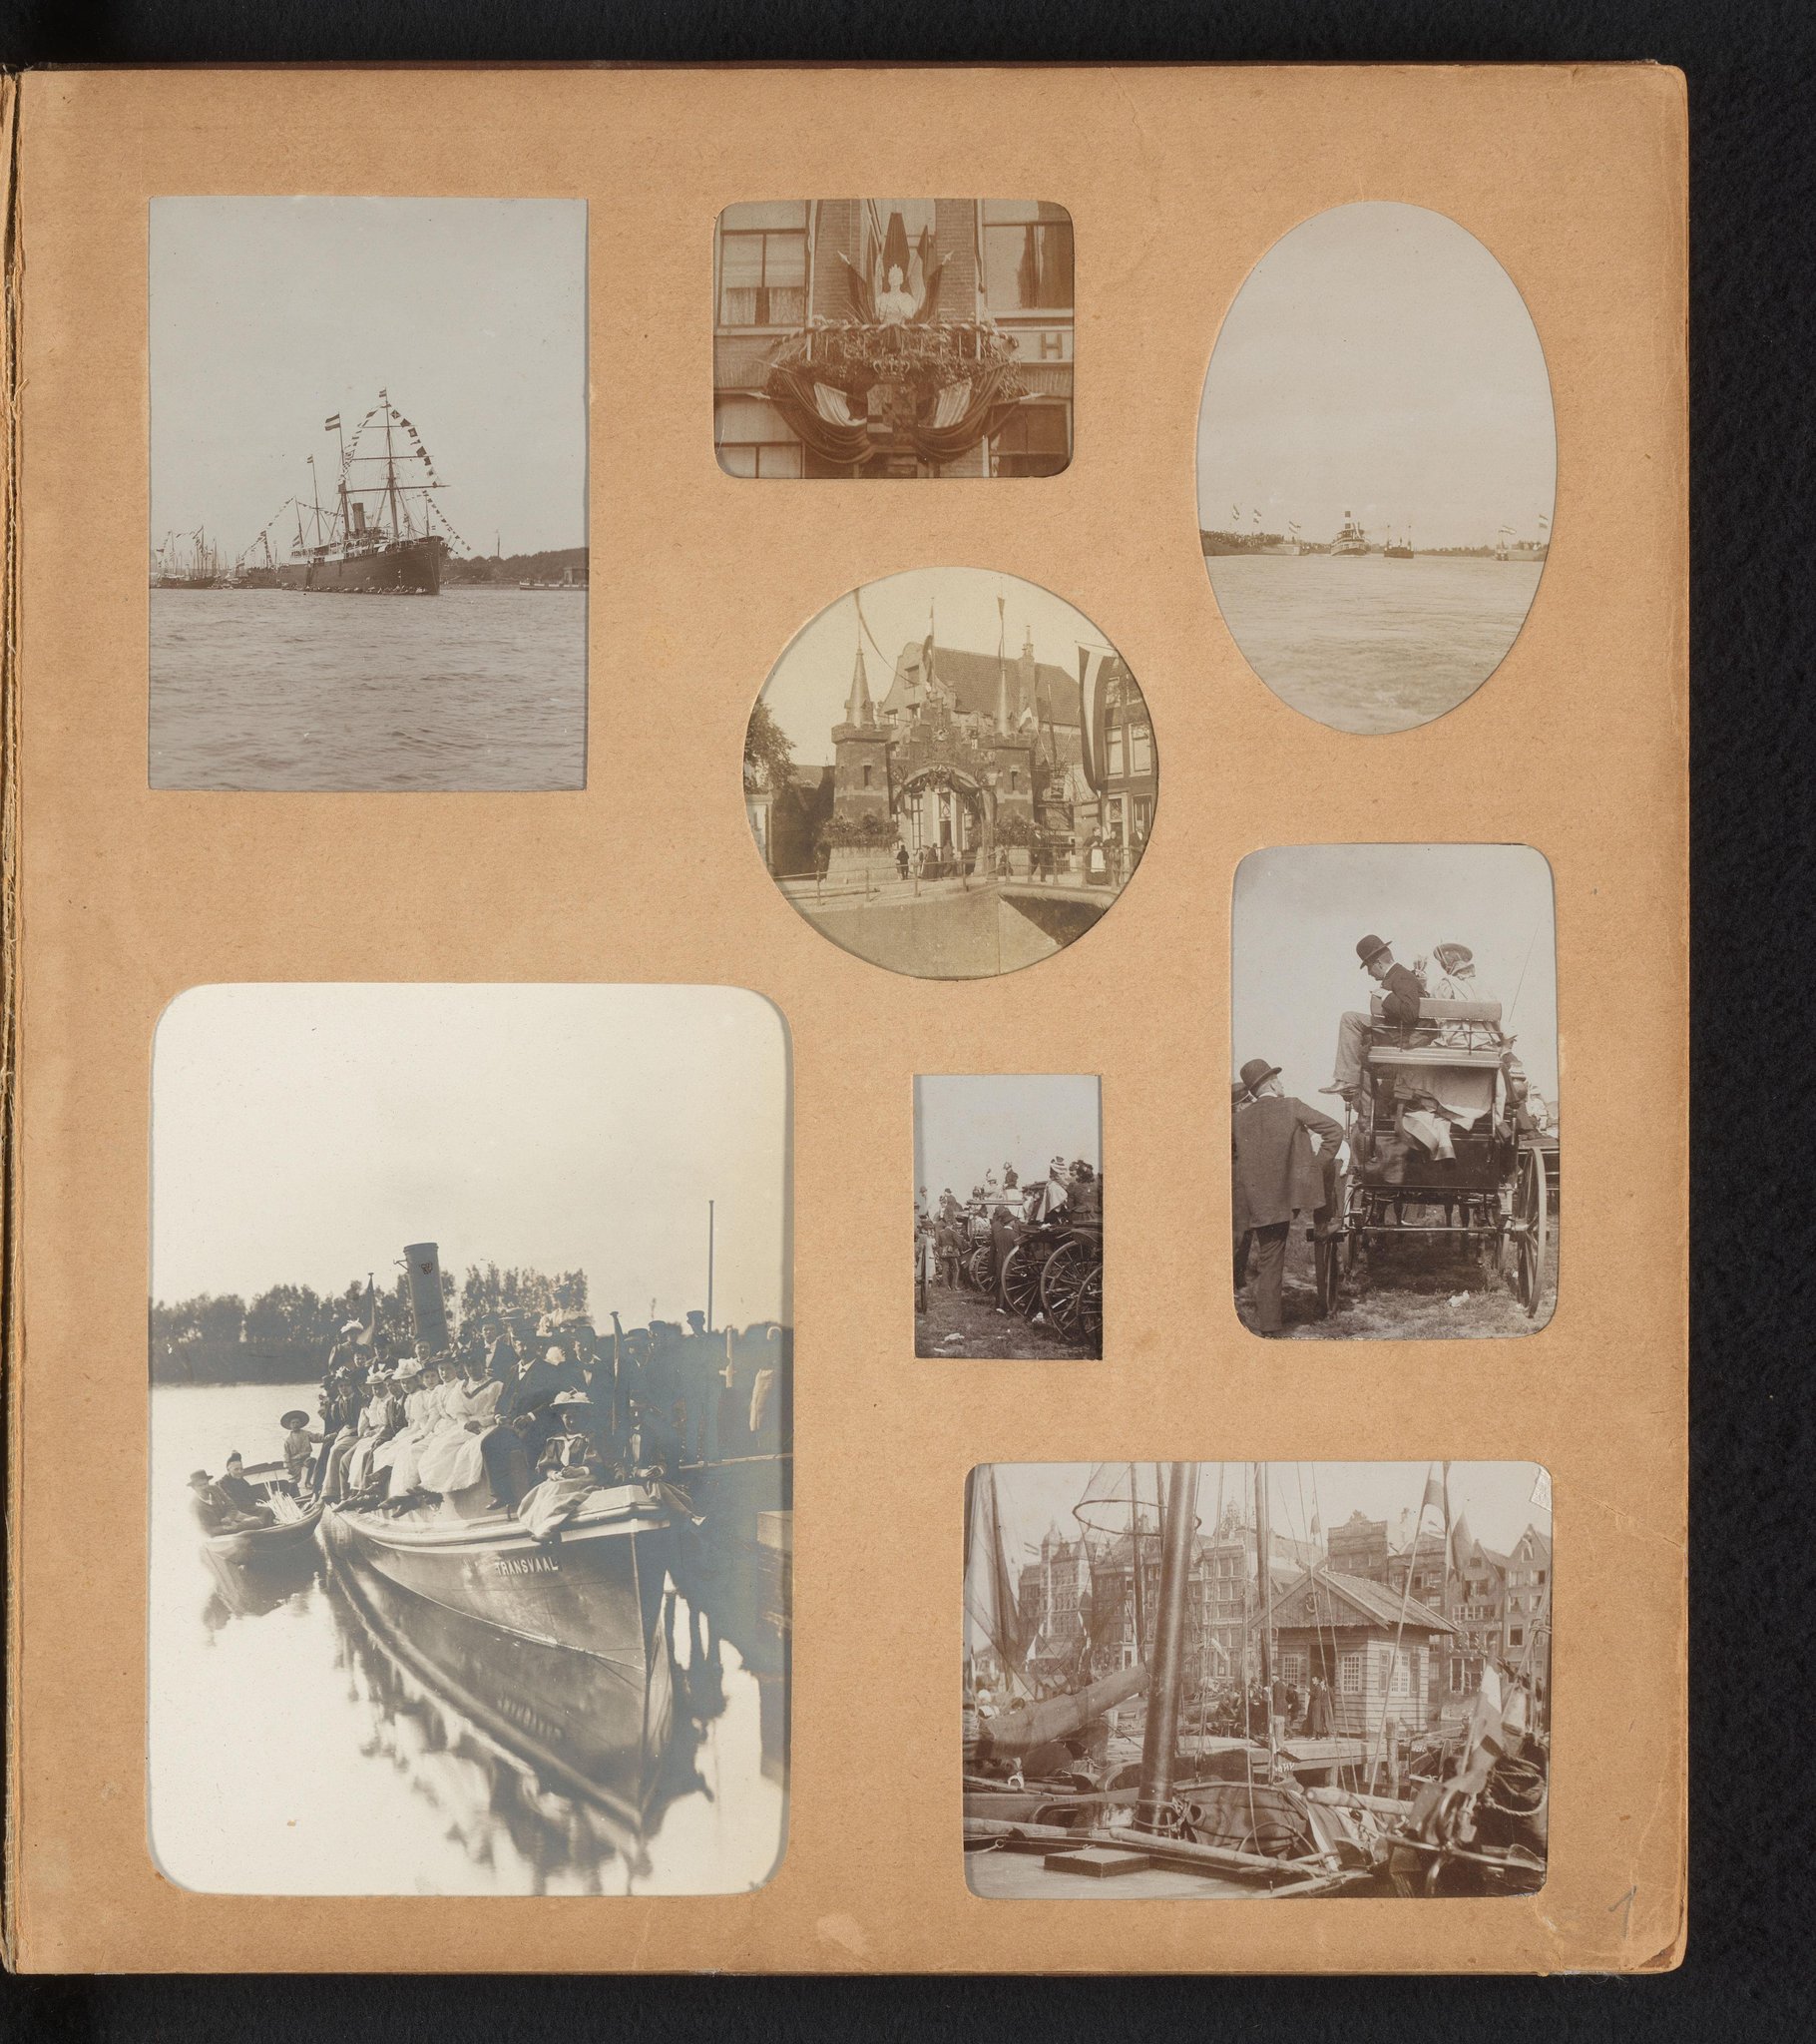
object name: album leaf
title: Gezichten op steden, boten en havens en een gezelschap in koetsen en in een boot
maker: machiel gerrit george suyver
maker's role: fotograaf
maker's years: 1872-1933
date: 1890-1898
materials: paper, cardboard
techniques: gelatin silver print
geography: netherlands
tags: the hague, print maker, wilhelmina of the netherlands, harbour, four-wheeled, animal-drawn vehicle, e.g.: cab, carriage, coach, outing, pleasure trip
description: Onder andere decoraties ter gelegenheid van de inhuldiging van Wilhelmina, een gezelschap op een schip genaamd Transvaal en rijtuigen op de Renkumse heide. Deze foto's maken deel uit van een album.